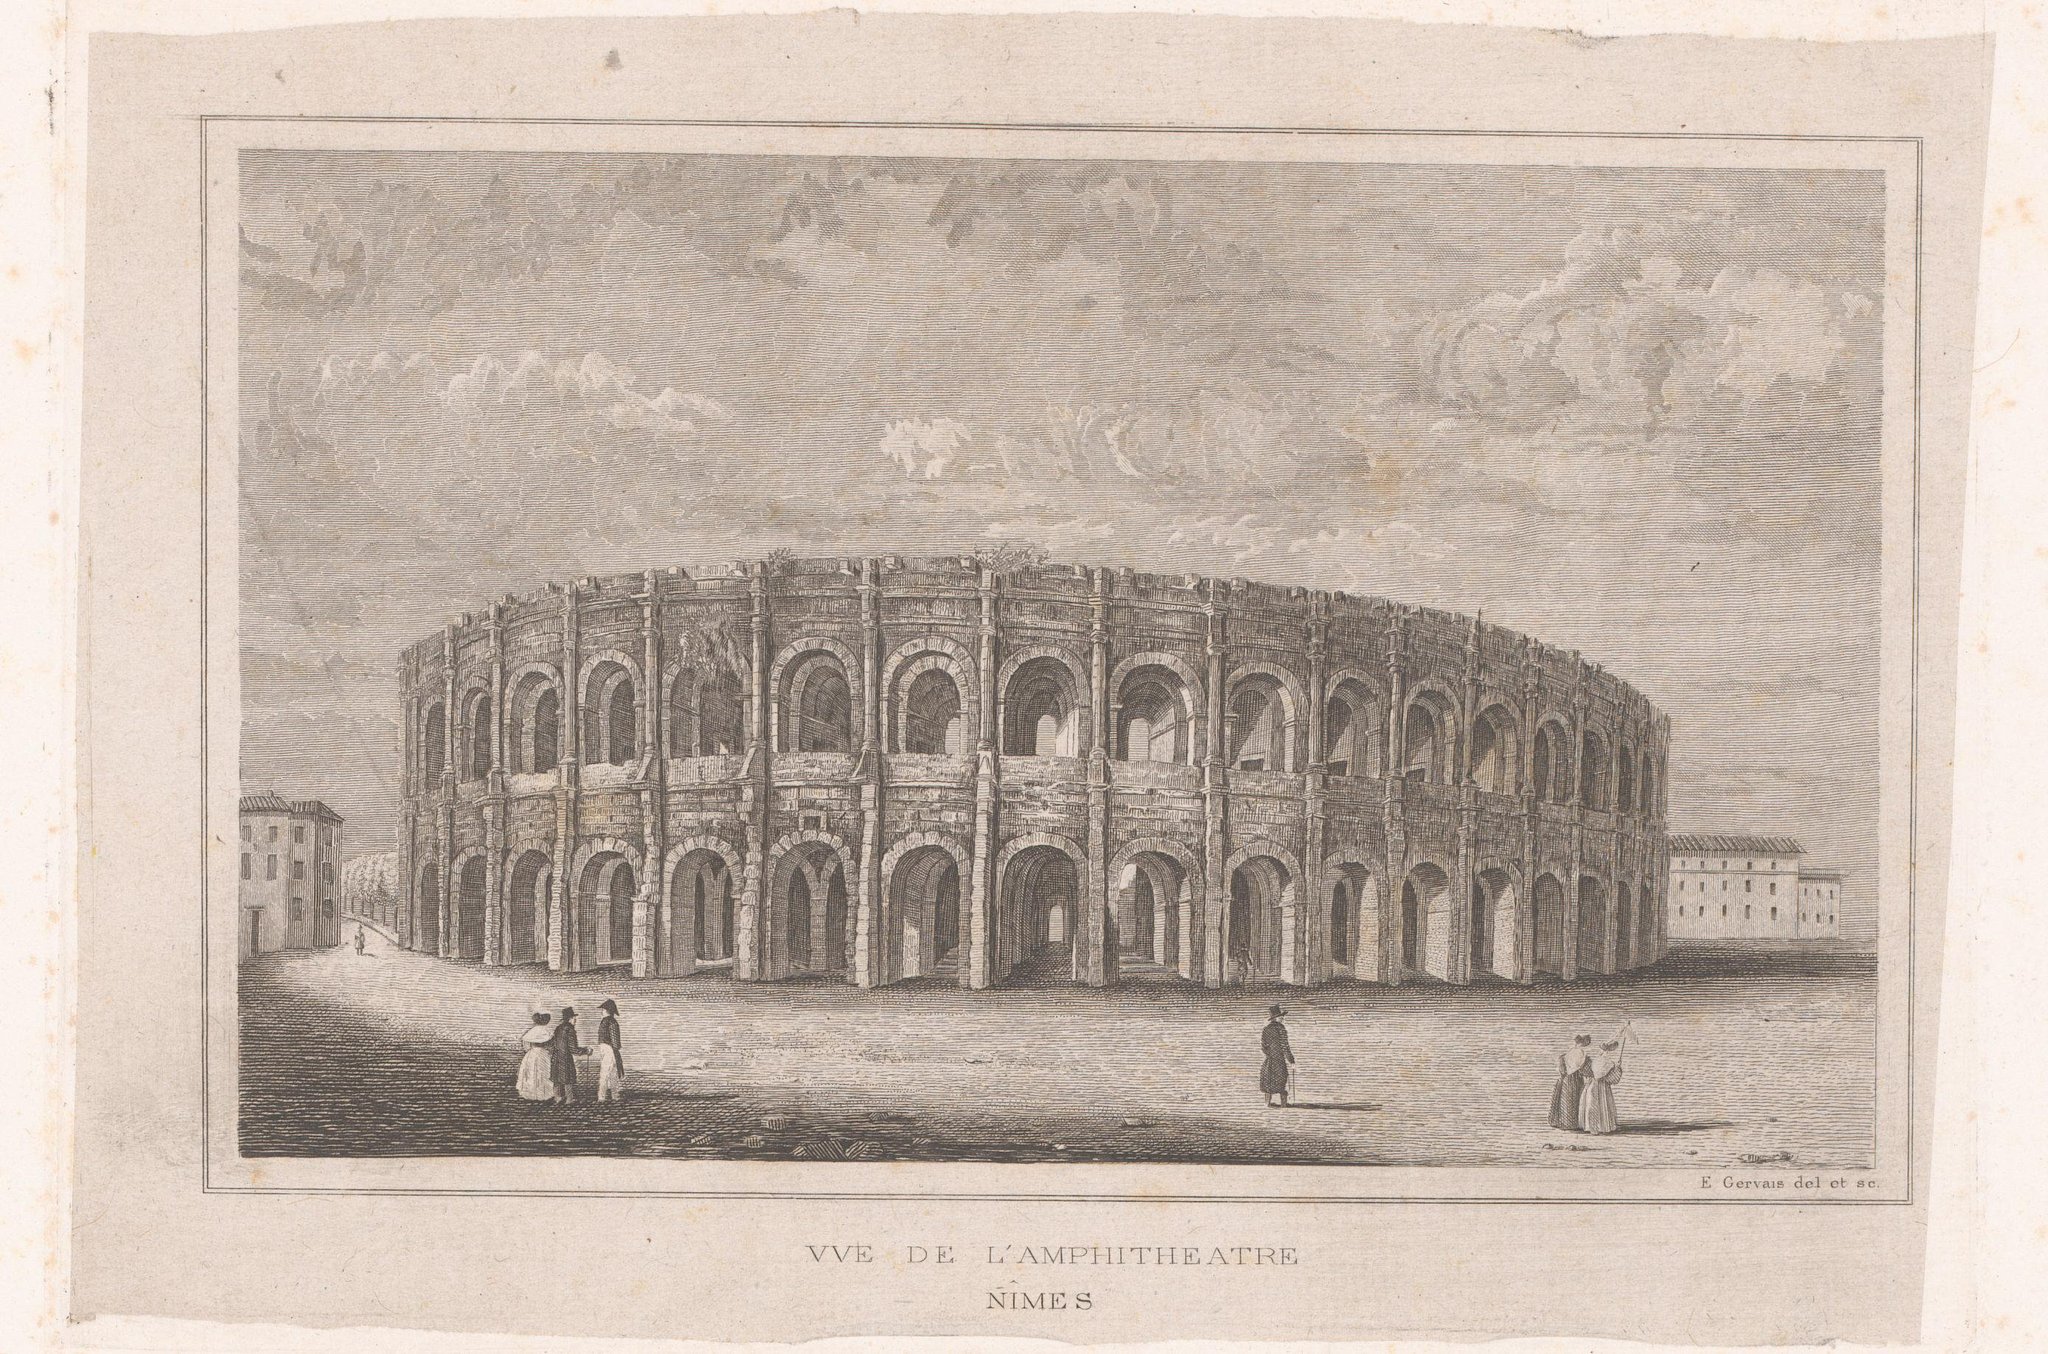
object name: print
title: Vue de l'amphitheatre Nimes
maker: eugène gervais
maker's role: painter, print maker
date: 1846-1880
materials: paper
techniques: engraving, etching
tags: amphitheatre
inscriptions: collector's mark: Lugt 2228